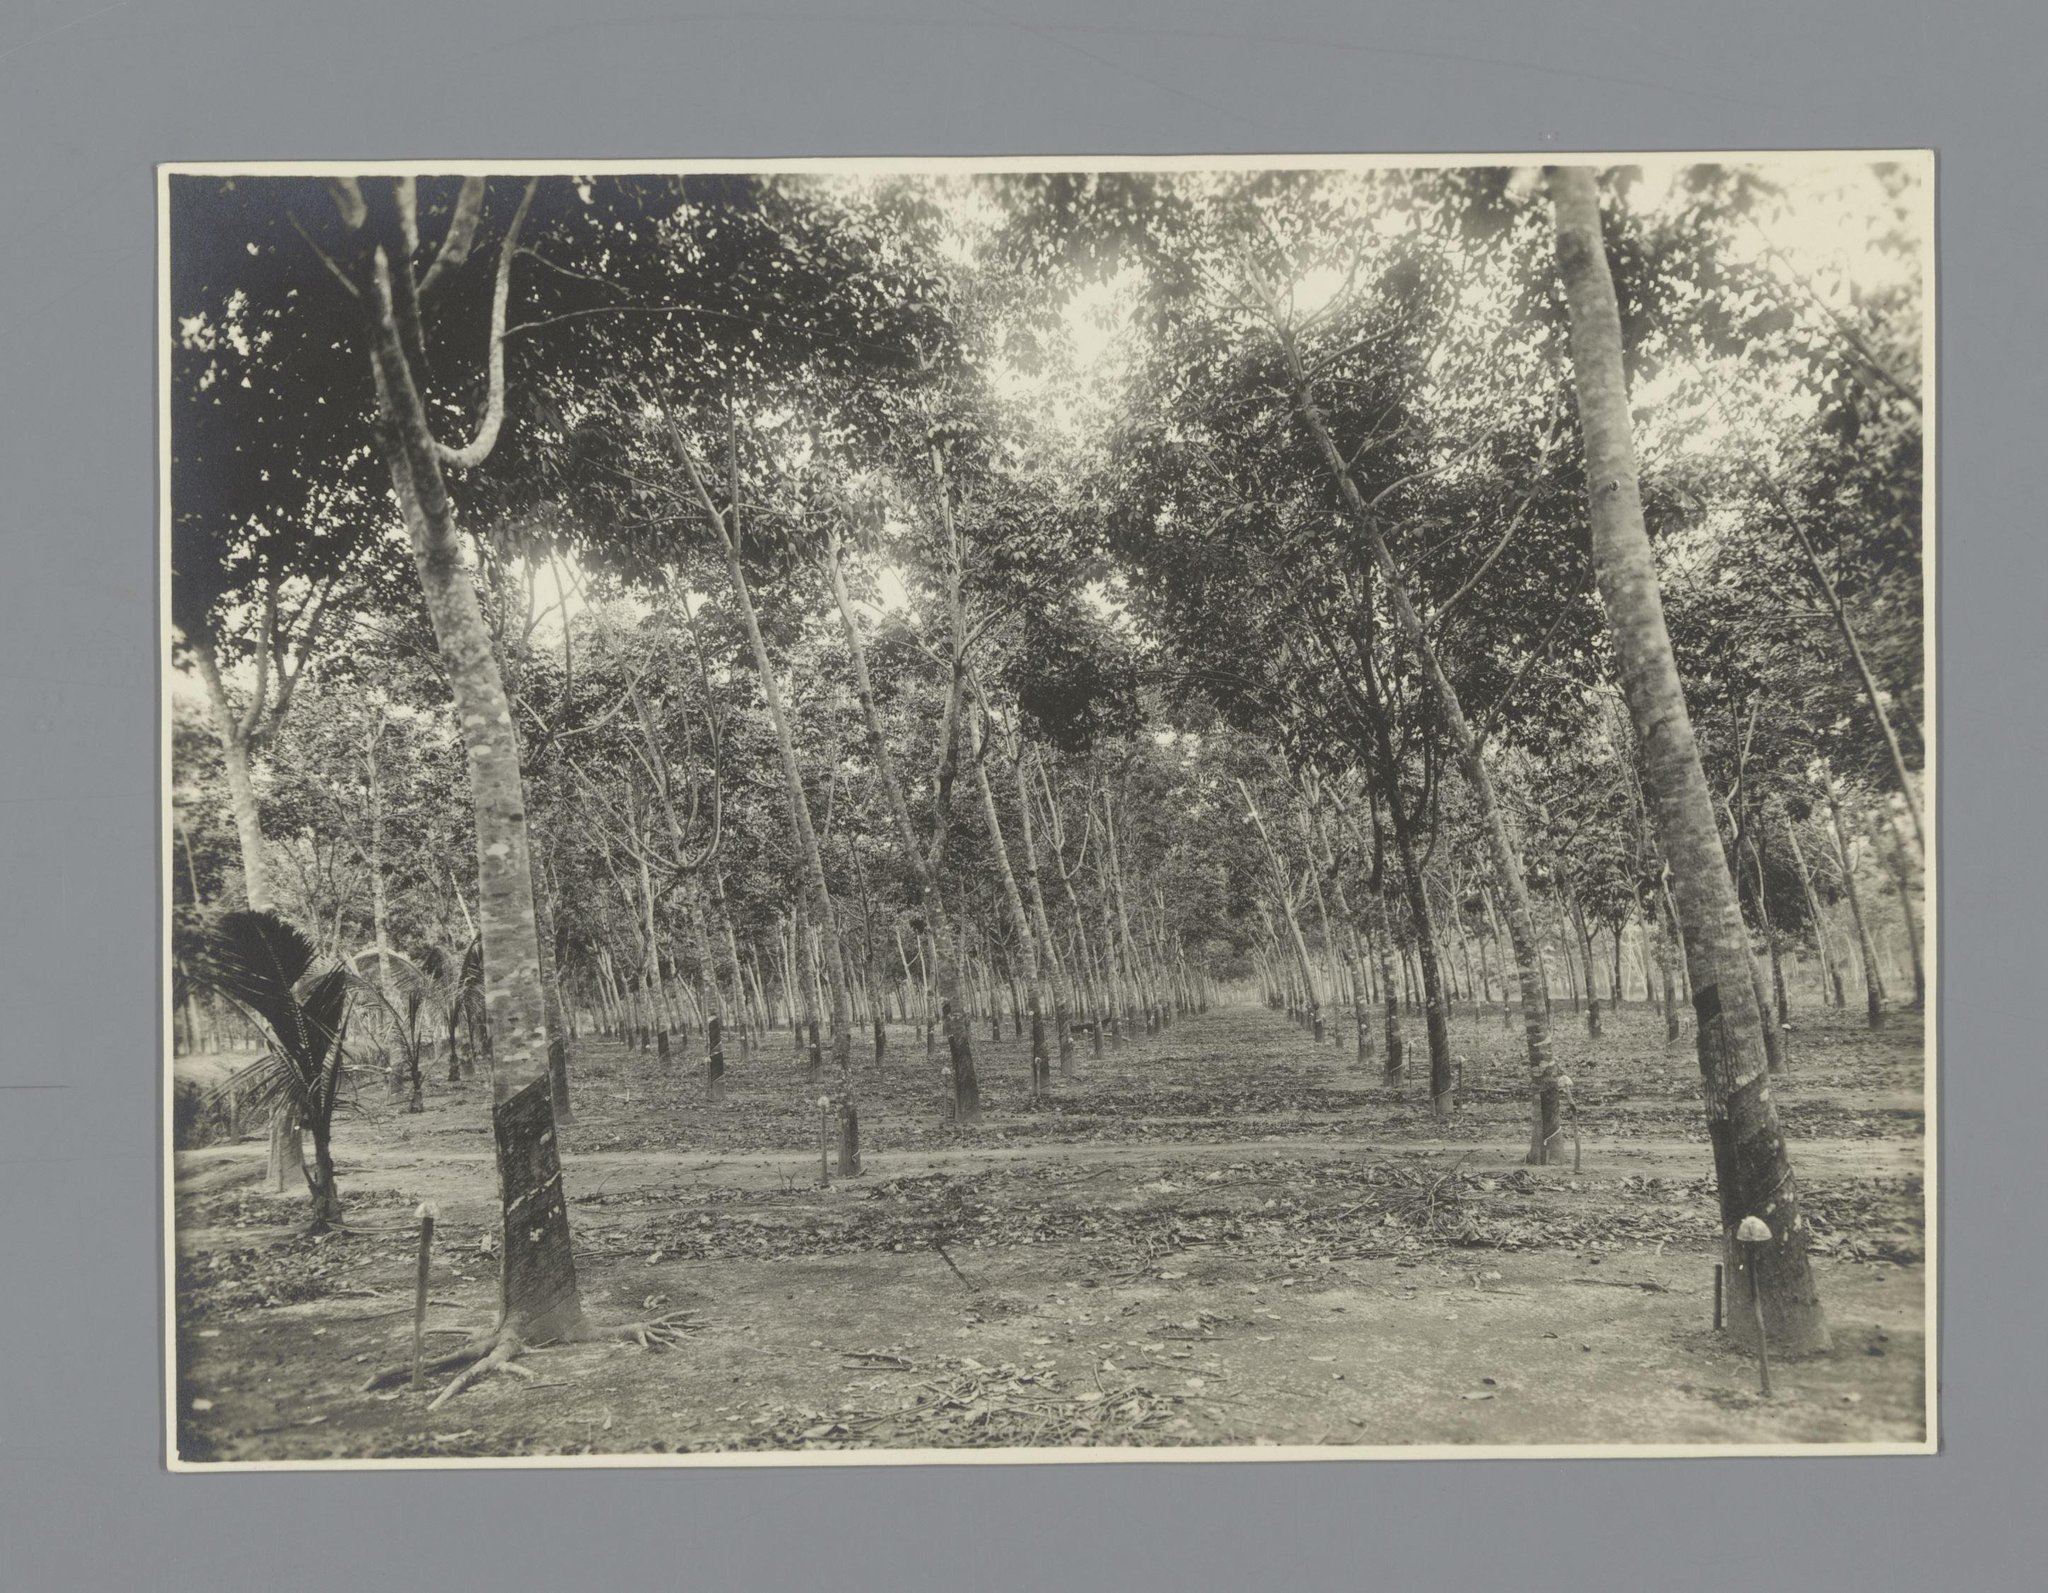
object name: photograph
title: Rubberbomen op de rubberplantage Boekit Pajong, Sumatra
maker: Anonymous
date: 1920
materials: paper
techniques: gelatin silver print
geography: tandjong poera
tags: plantation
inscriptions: inscription: ‘23./ so sah der anpflanz zu/ meiner Zeit aus/ 1920/ 20.’